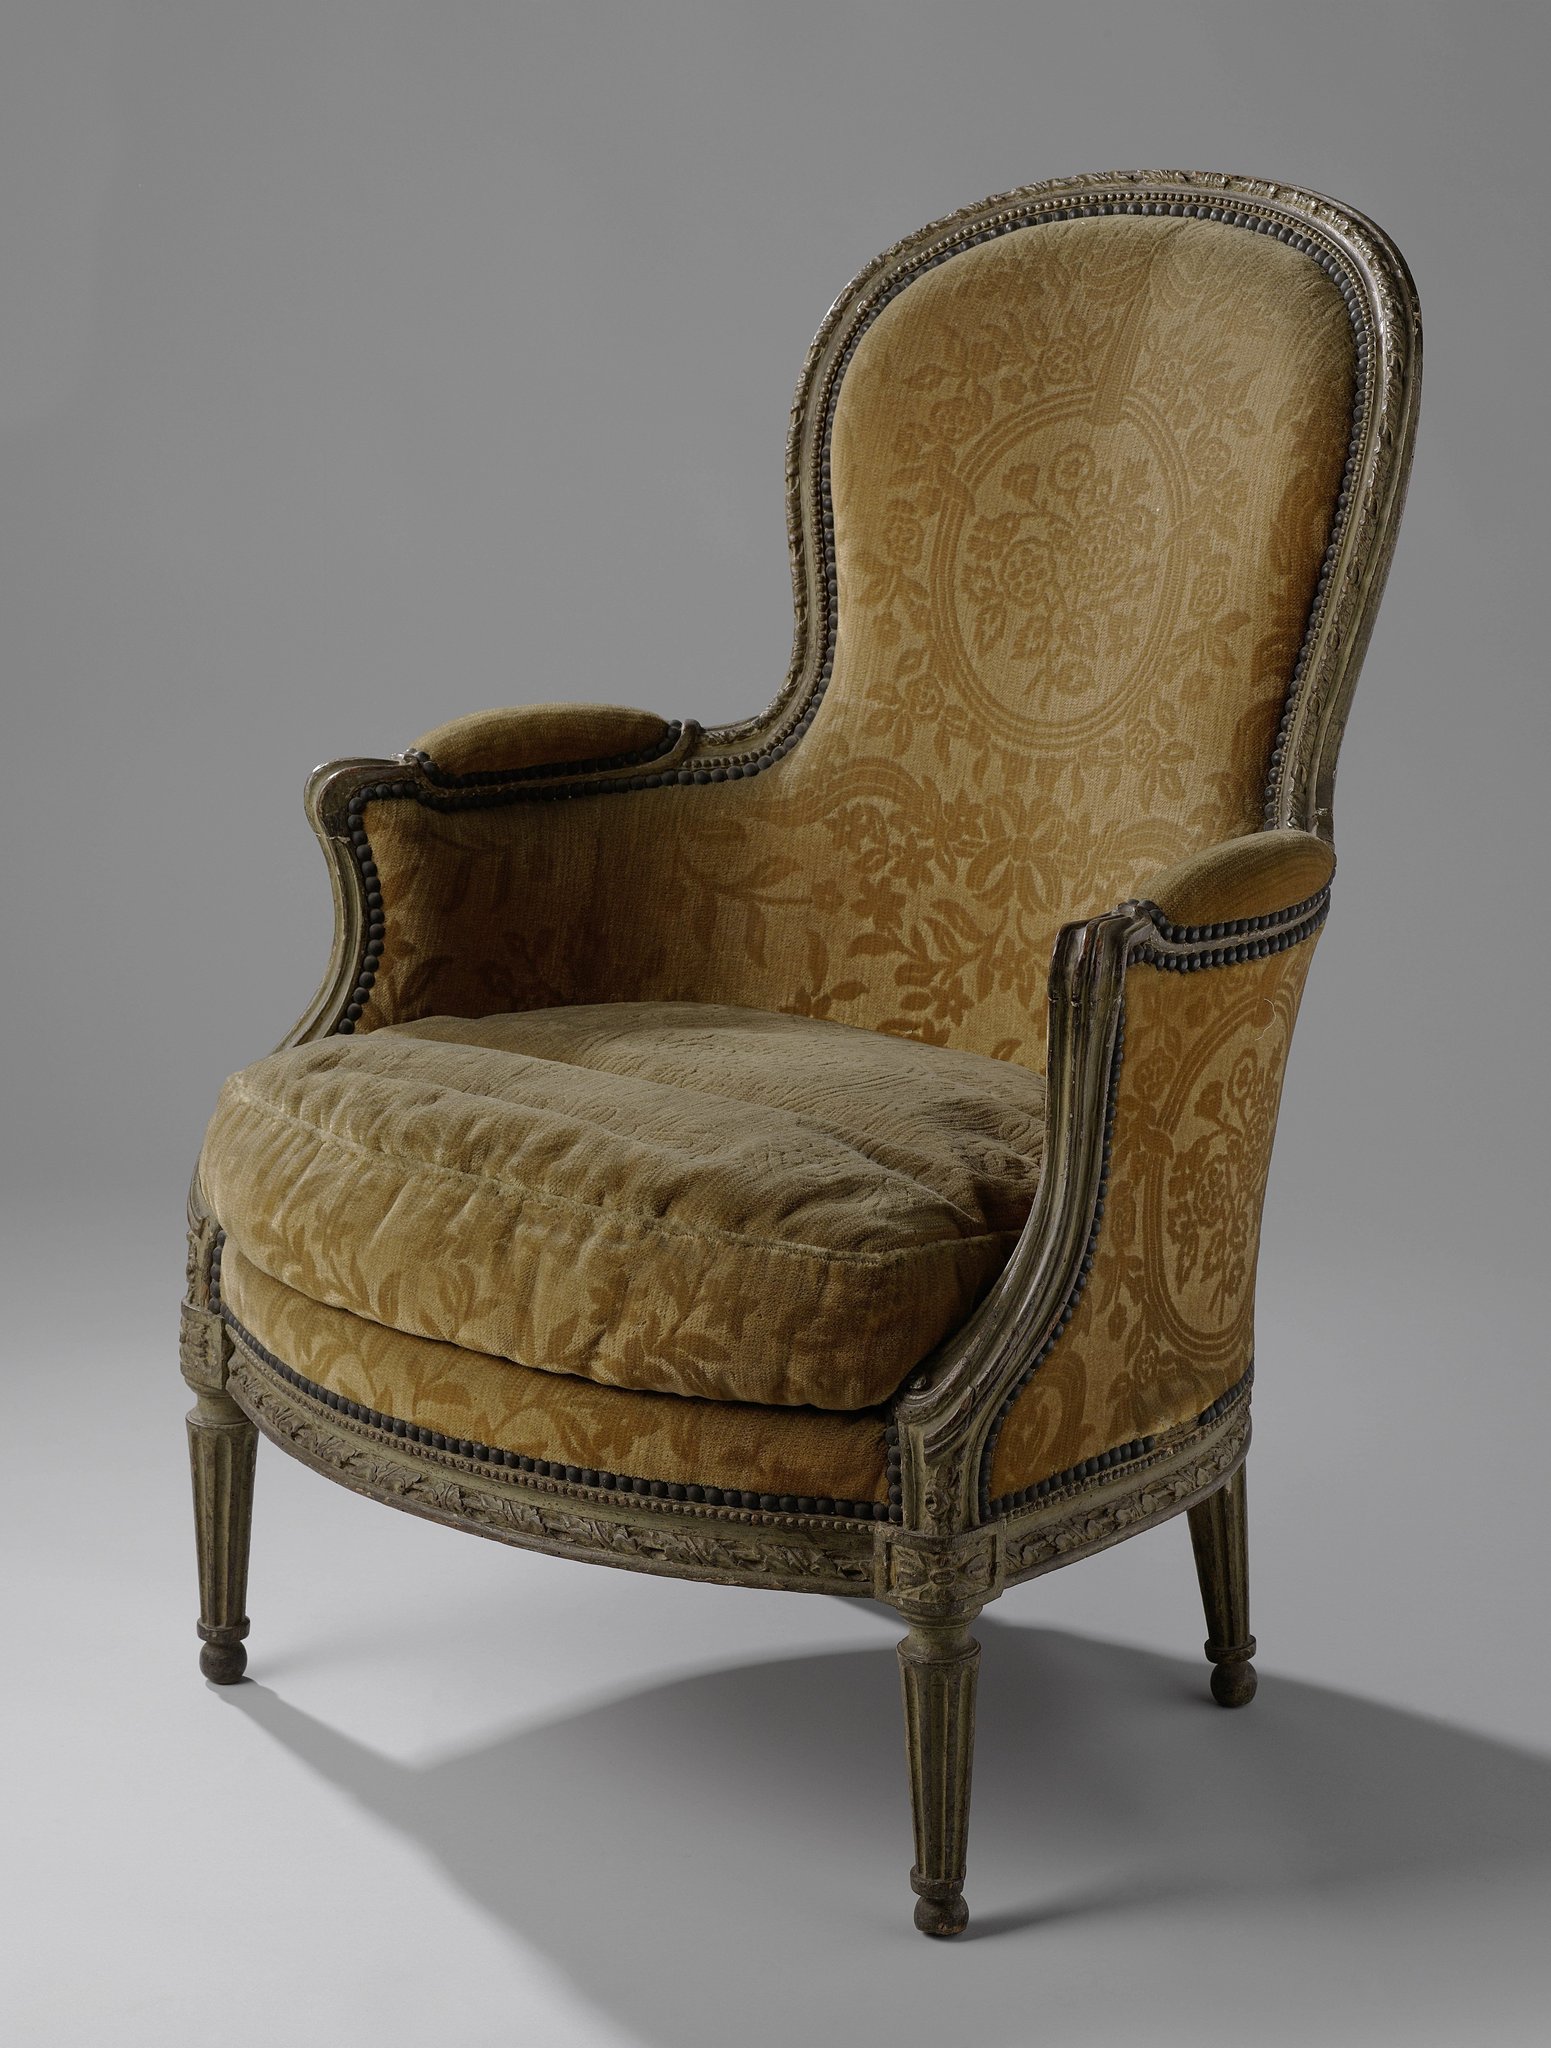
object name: bergère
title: Bergère van wit geschilderd beukenhout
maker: adrien pierre dupain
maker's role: furniture worker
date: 1775-1800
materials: wood, paint, textile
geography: france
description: Bergère van wit geschilderd beukenhout. Het meubel is bekleed, heeft een los kussen en rust op conische gecanneleerde poten, waarboven vierkante huizen met rozetten. De geprofileerde S-vormige armleggerstutten gaan in de voluten van de armleggers over. Deze hebben kussentjes en zijn verbonden met het ronde, bij de aanvangspunten licht ingesnoerde, raam van de geholde rug. Het rugraam en de zitregels hebben een gestoken ornament van smal acanthusblad, dat om een staaf is geslingerd. Gestempeld: A.P. Dupain.